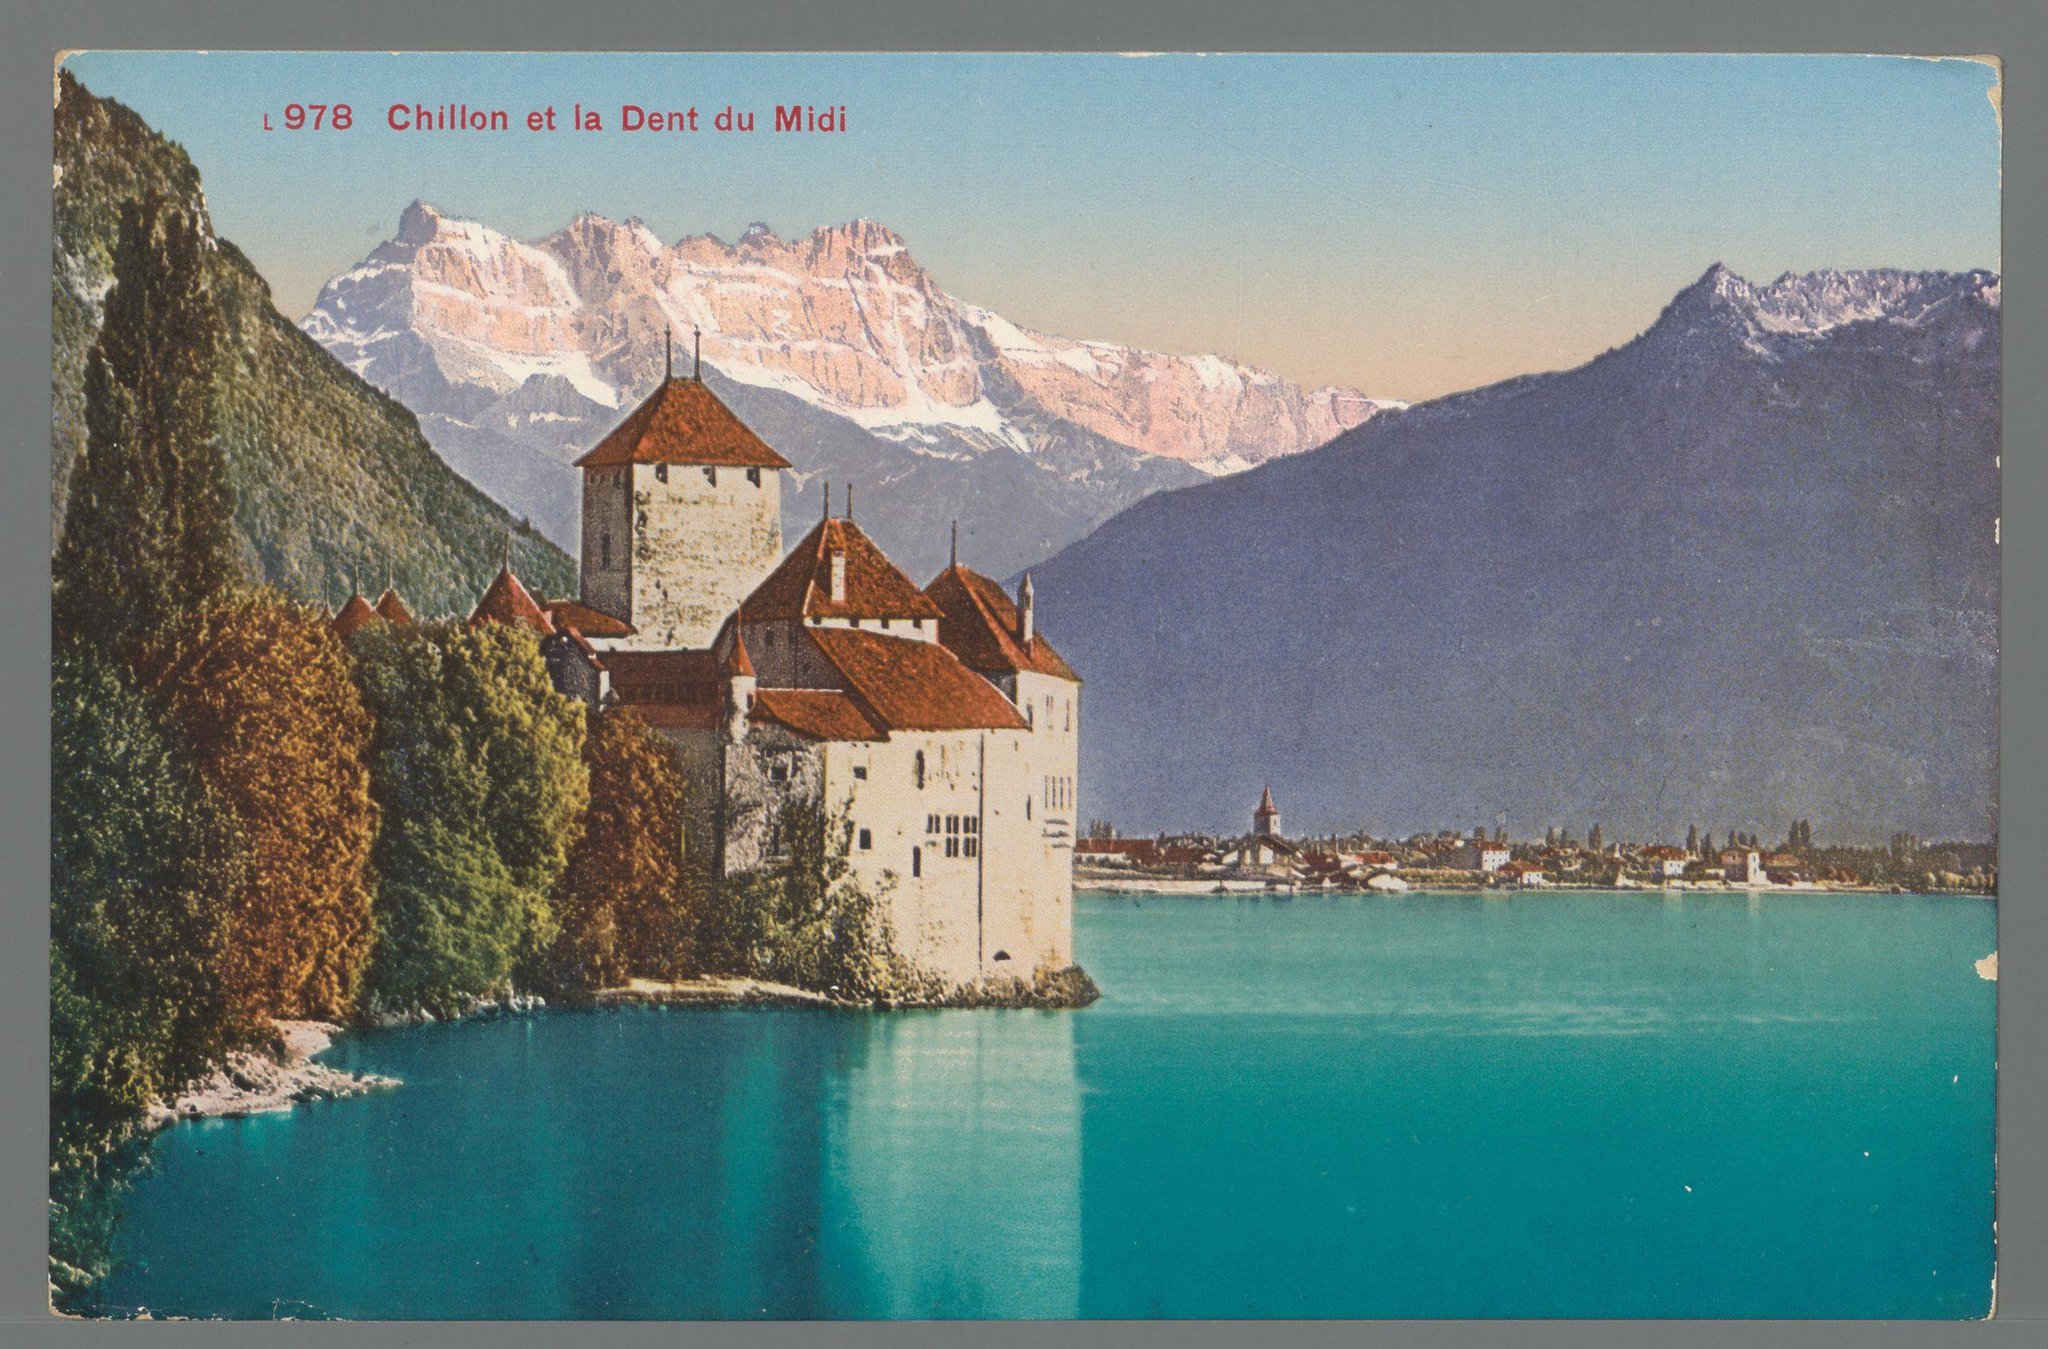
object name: photomechanical print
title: Chillon et la Dent du Midi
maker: Anonymous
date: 1905-1930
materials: cardboard, photographic process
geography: montreux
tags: castle, railway, train, mountain-range, snow peaks